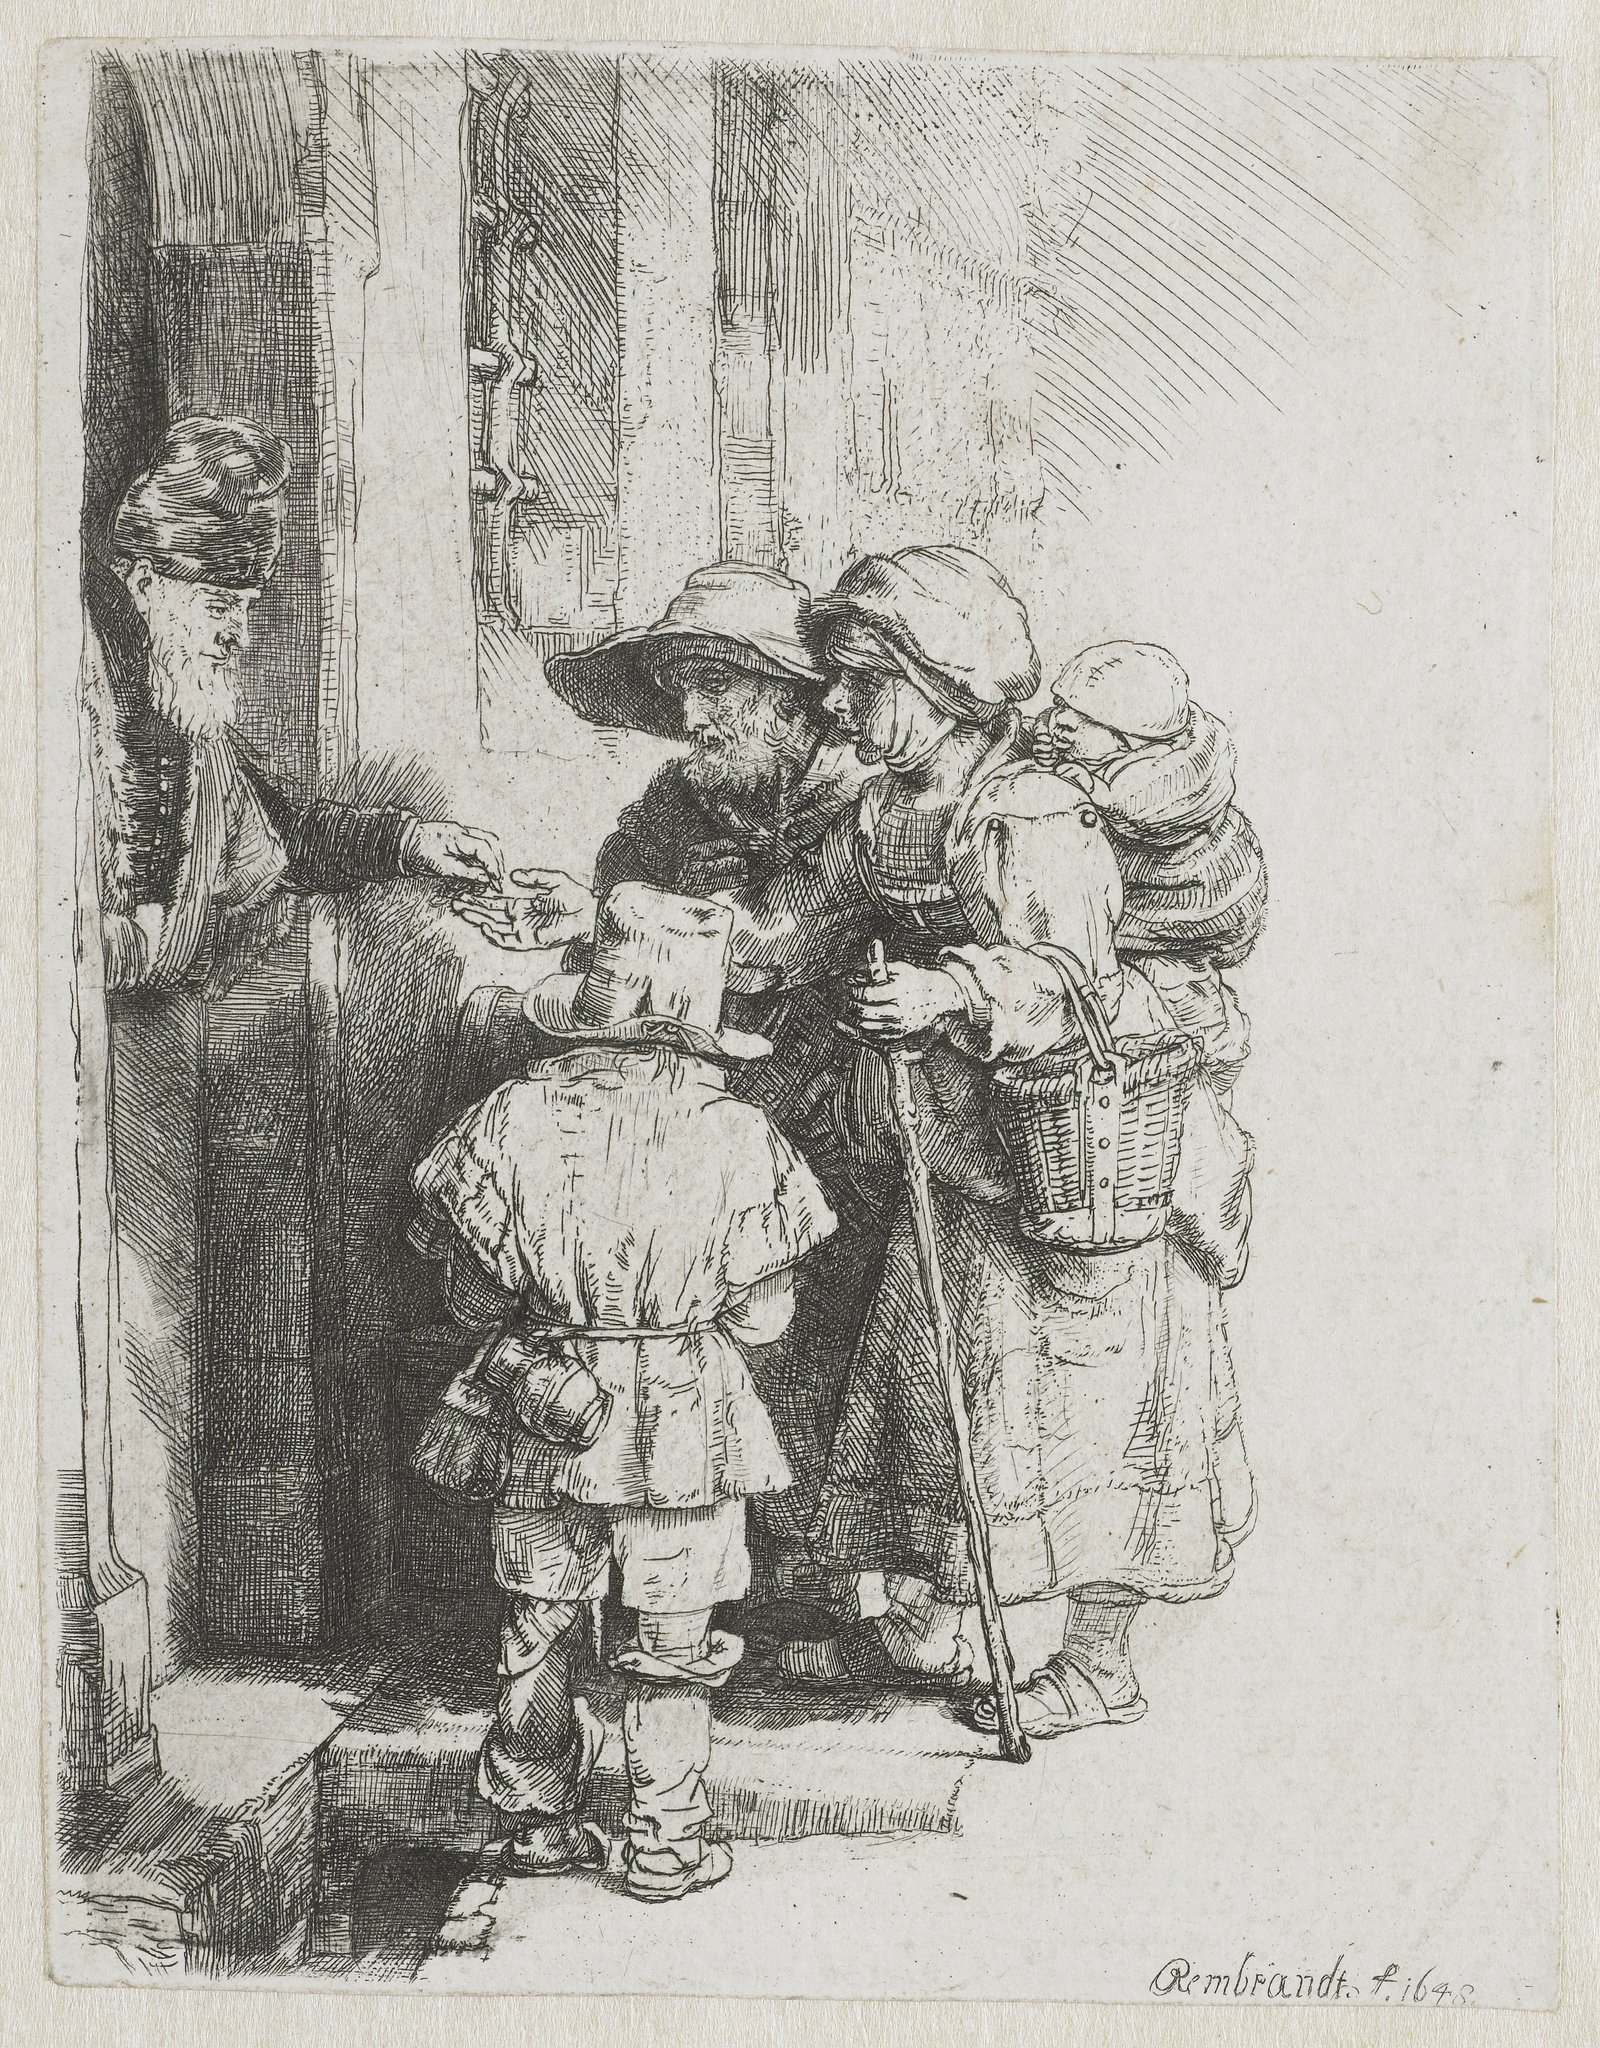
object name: print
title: A blind hurdy-gurdy player and family receiving alms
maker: rembrandt van rijn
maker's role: draughtsman, painter, print maker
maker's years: 1606-1669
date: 1648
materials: paper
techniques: drypoint, etching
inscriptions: collector's mark: Lugt 2228 a, signature and date: ‘Rembrandt f. 1648’